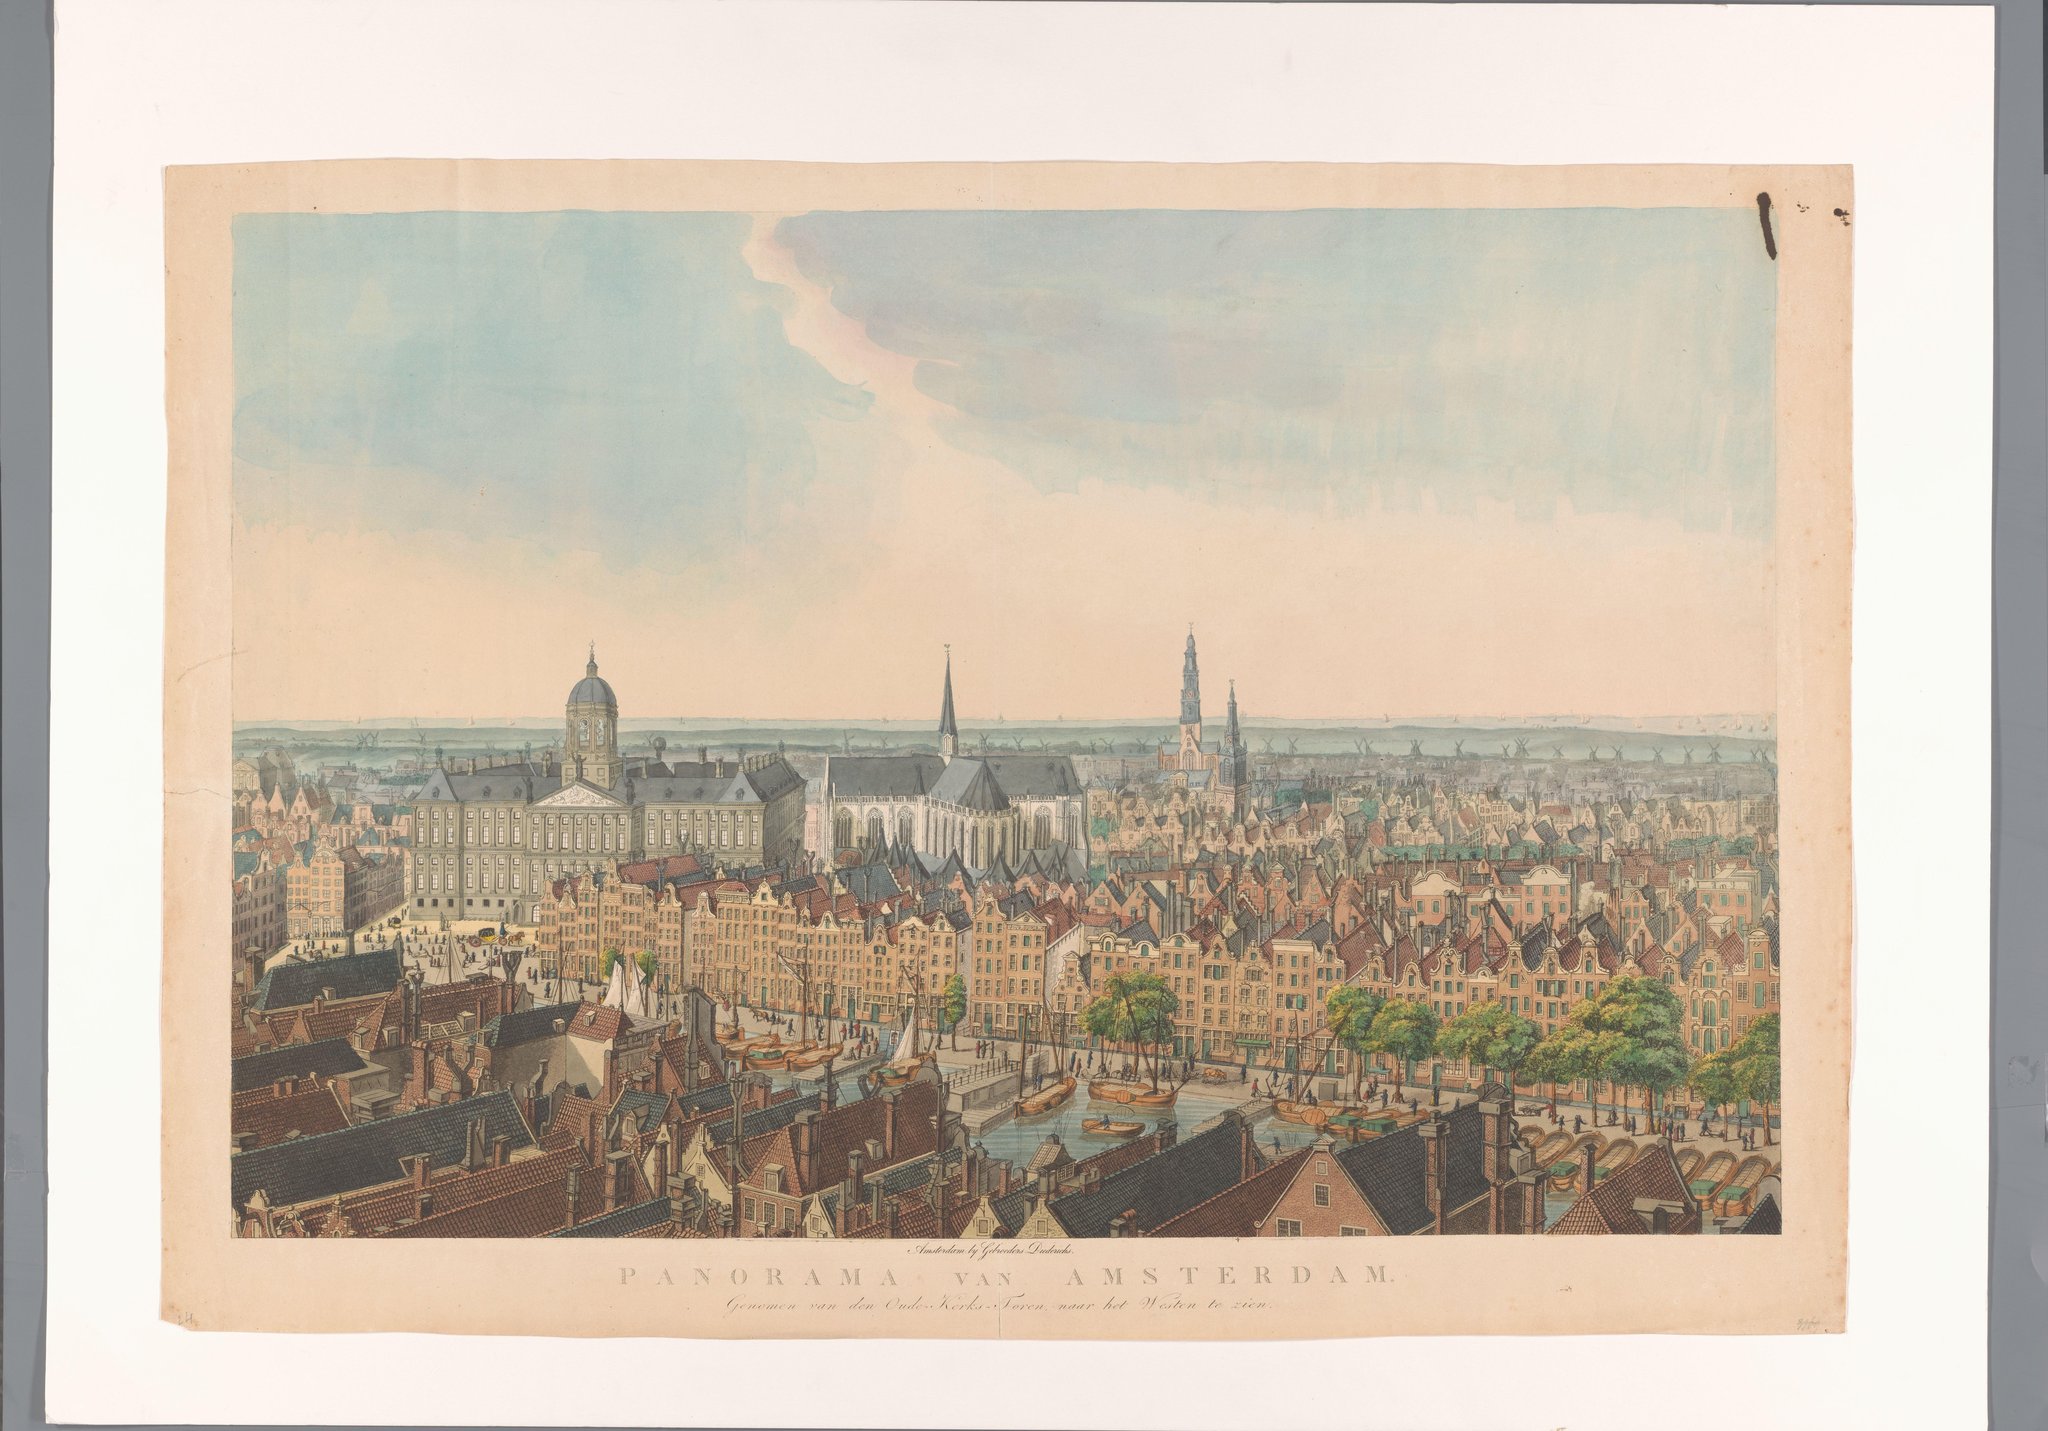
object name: print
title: Panorama van Amsterdam, met het Paleis op de Dam en de Nieuwe Kerk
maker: Anonymous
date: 1828-1865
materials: paper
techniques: lithograph, hand coloring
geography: amsterdam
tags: prospect of city, town panorama, silhouette of city, royal palace of amsterdam, amsterdam